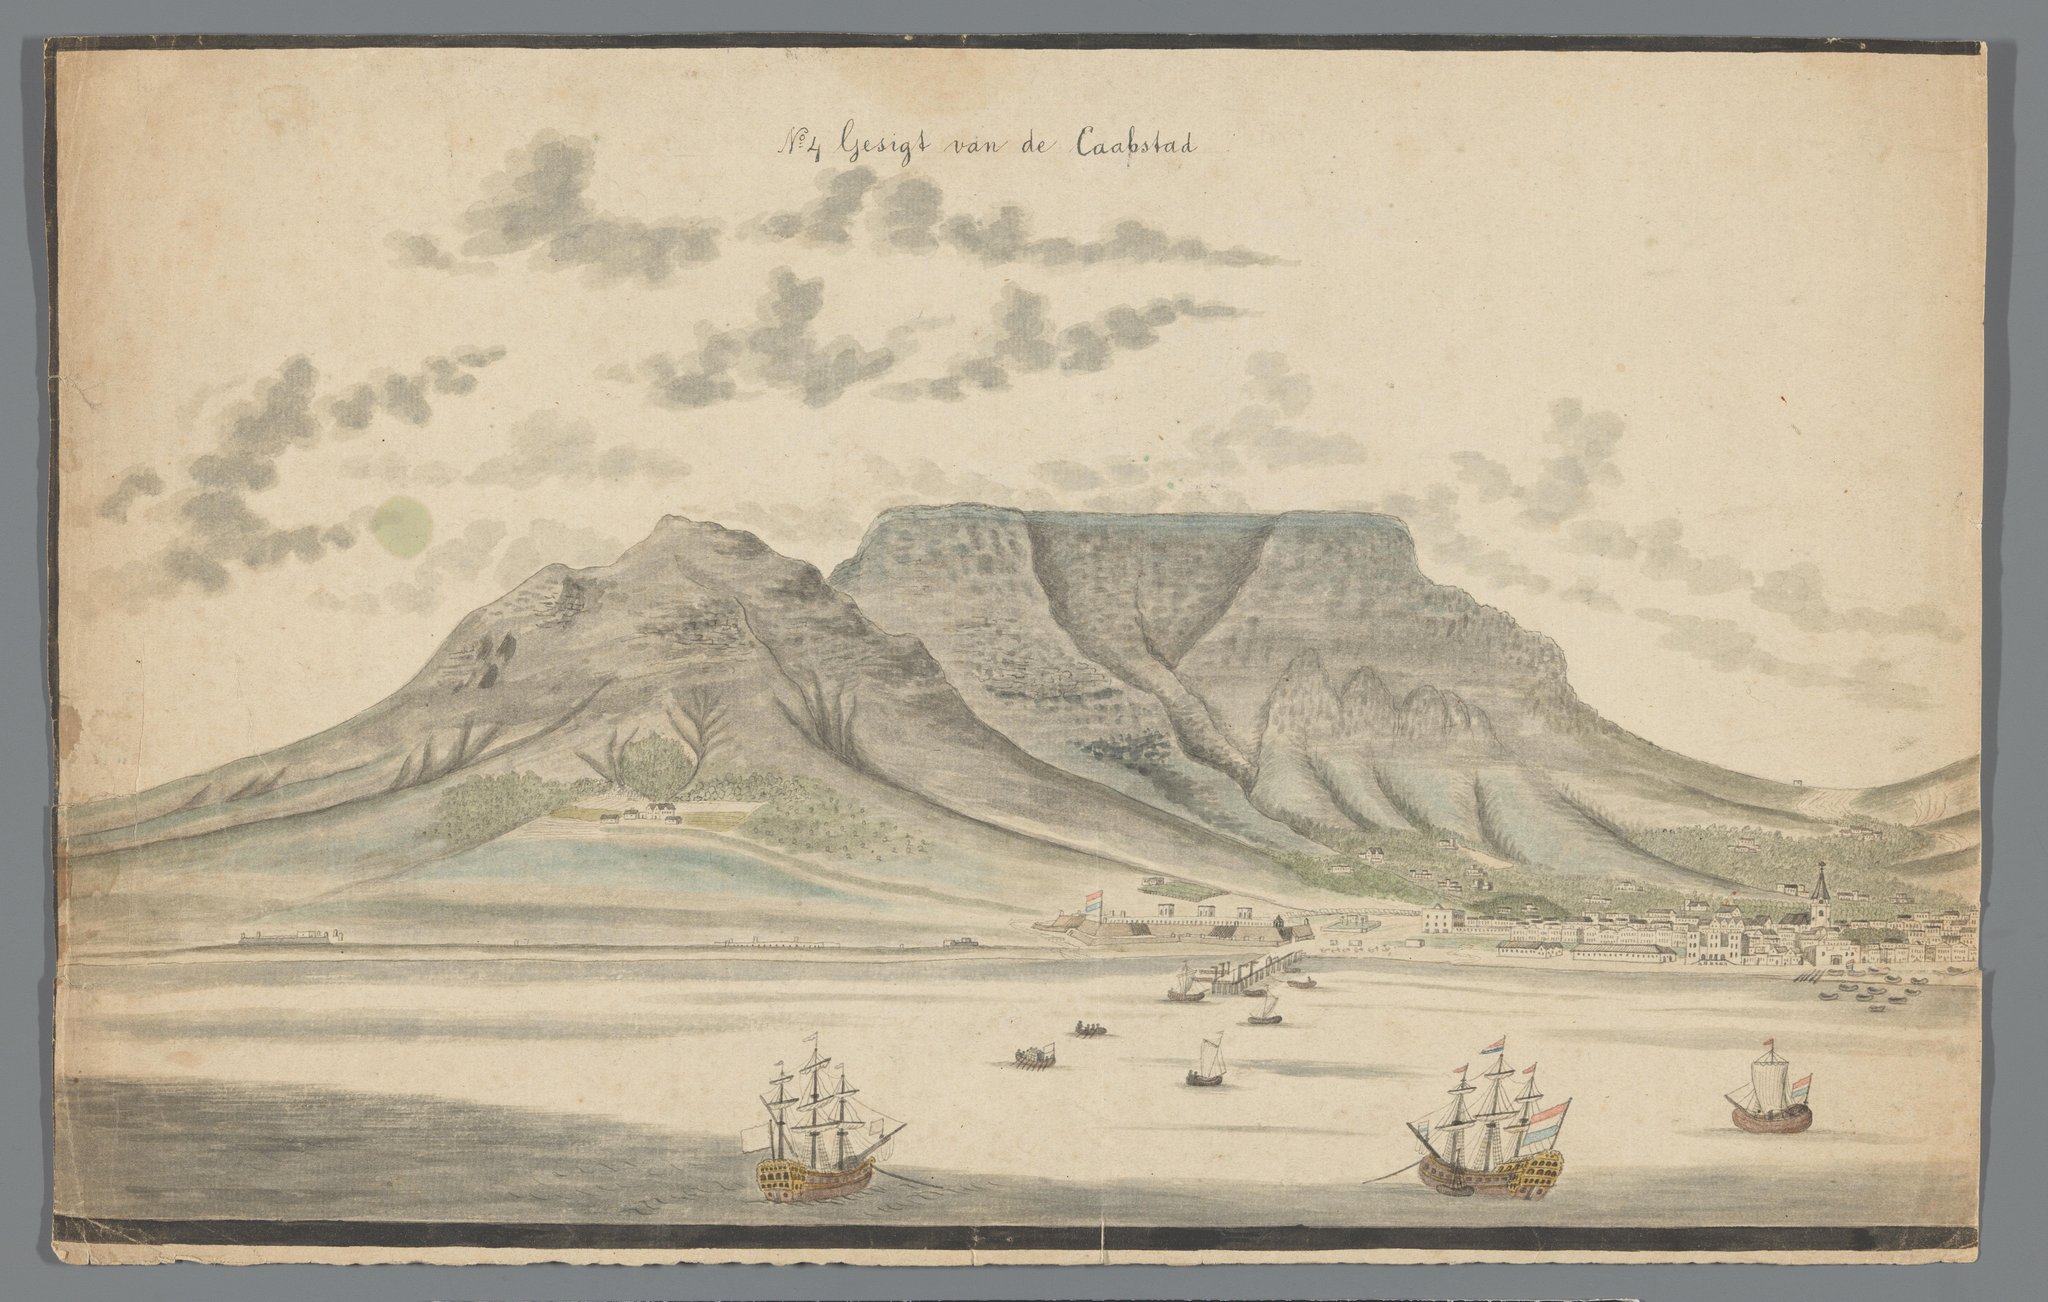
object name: drawing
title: Aquarellen betrekking hebbende op de drie reizen door de Kaap door Hendrik Swellengrebel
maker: johannes schumacher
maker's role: draughtsman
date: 1777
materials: paper, watercolor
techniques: brush, pen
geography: south africa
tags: cape of good hope, mountain-range, snow peaks, prospect of city, town panorama, silhouette of city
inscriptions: label: ‘62’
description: Panorama van Kaapstad en omgeving gezien vanaf zee. Op dit blad het westelijke deel van de stad met het Kasteel de Goede Hoop. Op de achtergrond de Tafelberg. Linkerhelft van een voorstelling bestaande uit twee helften.